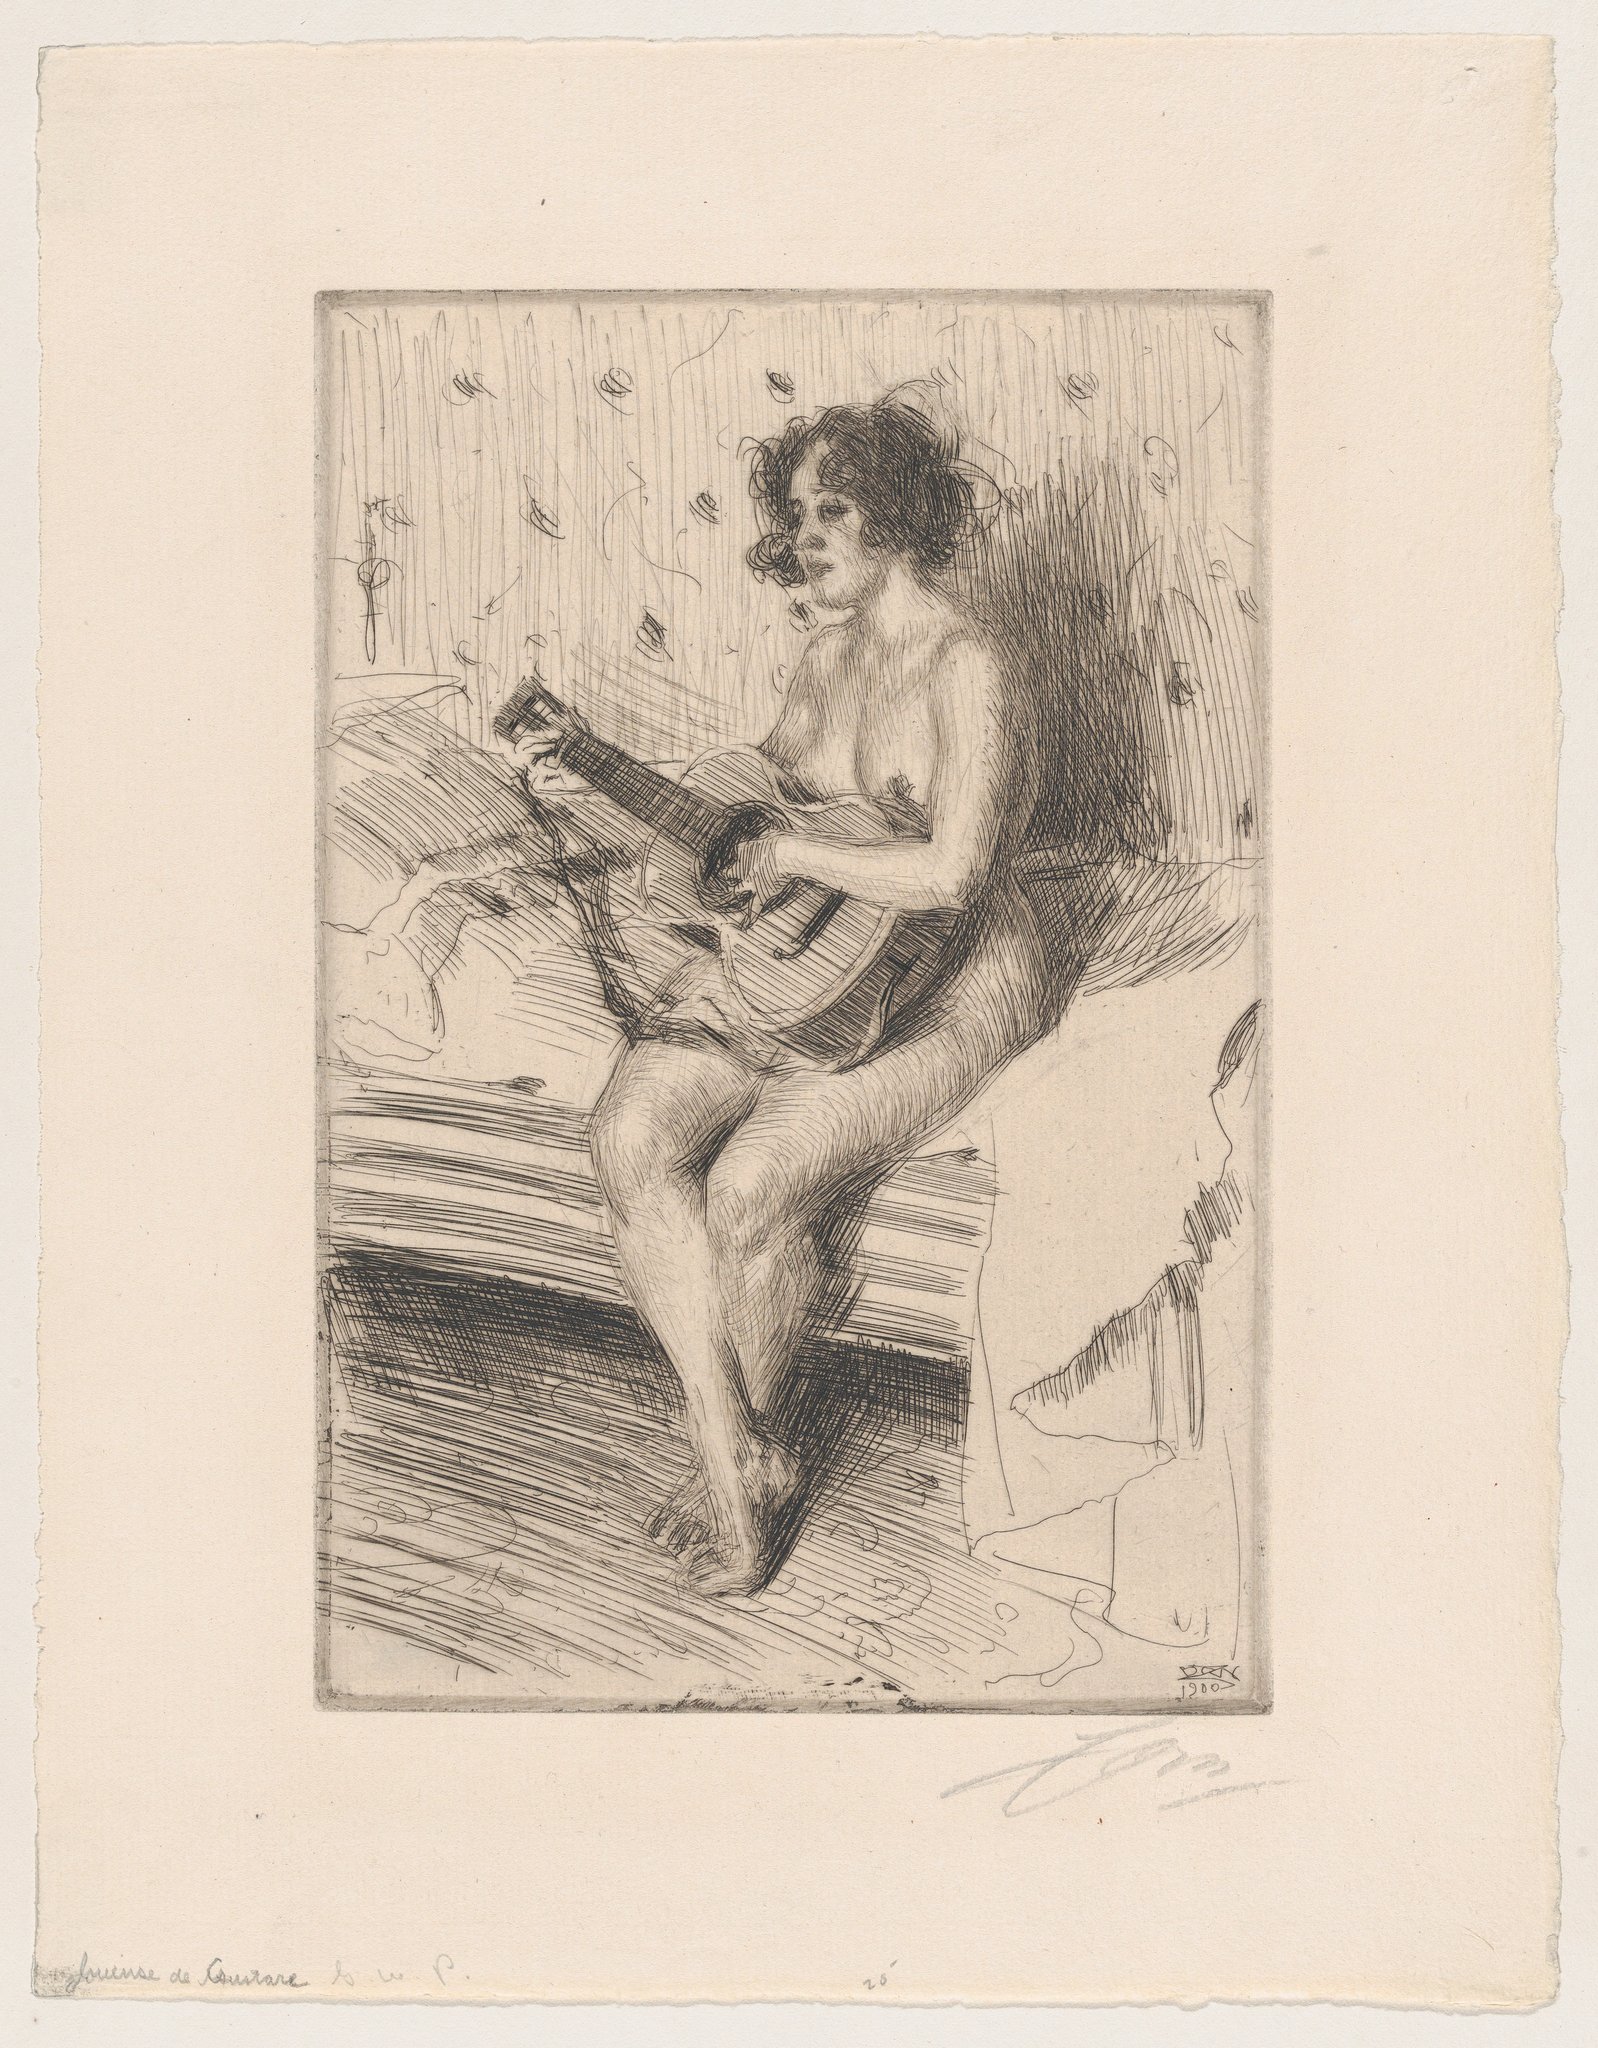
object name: print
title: The Guitar Player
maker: anders zorn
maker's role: artist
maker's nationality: swedish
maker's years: 1860-1920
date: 1900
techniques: etching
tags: female nudes,guitars,musicians